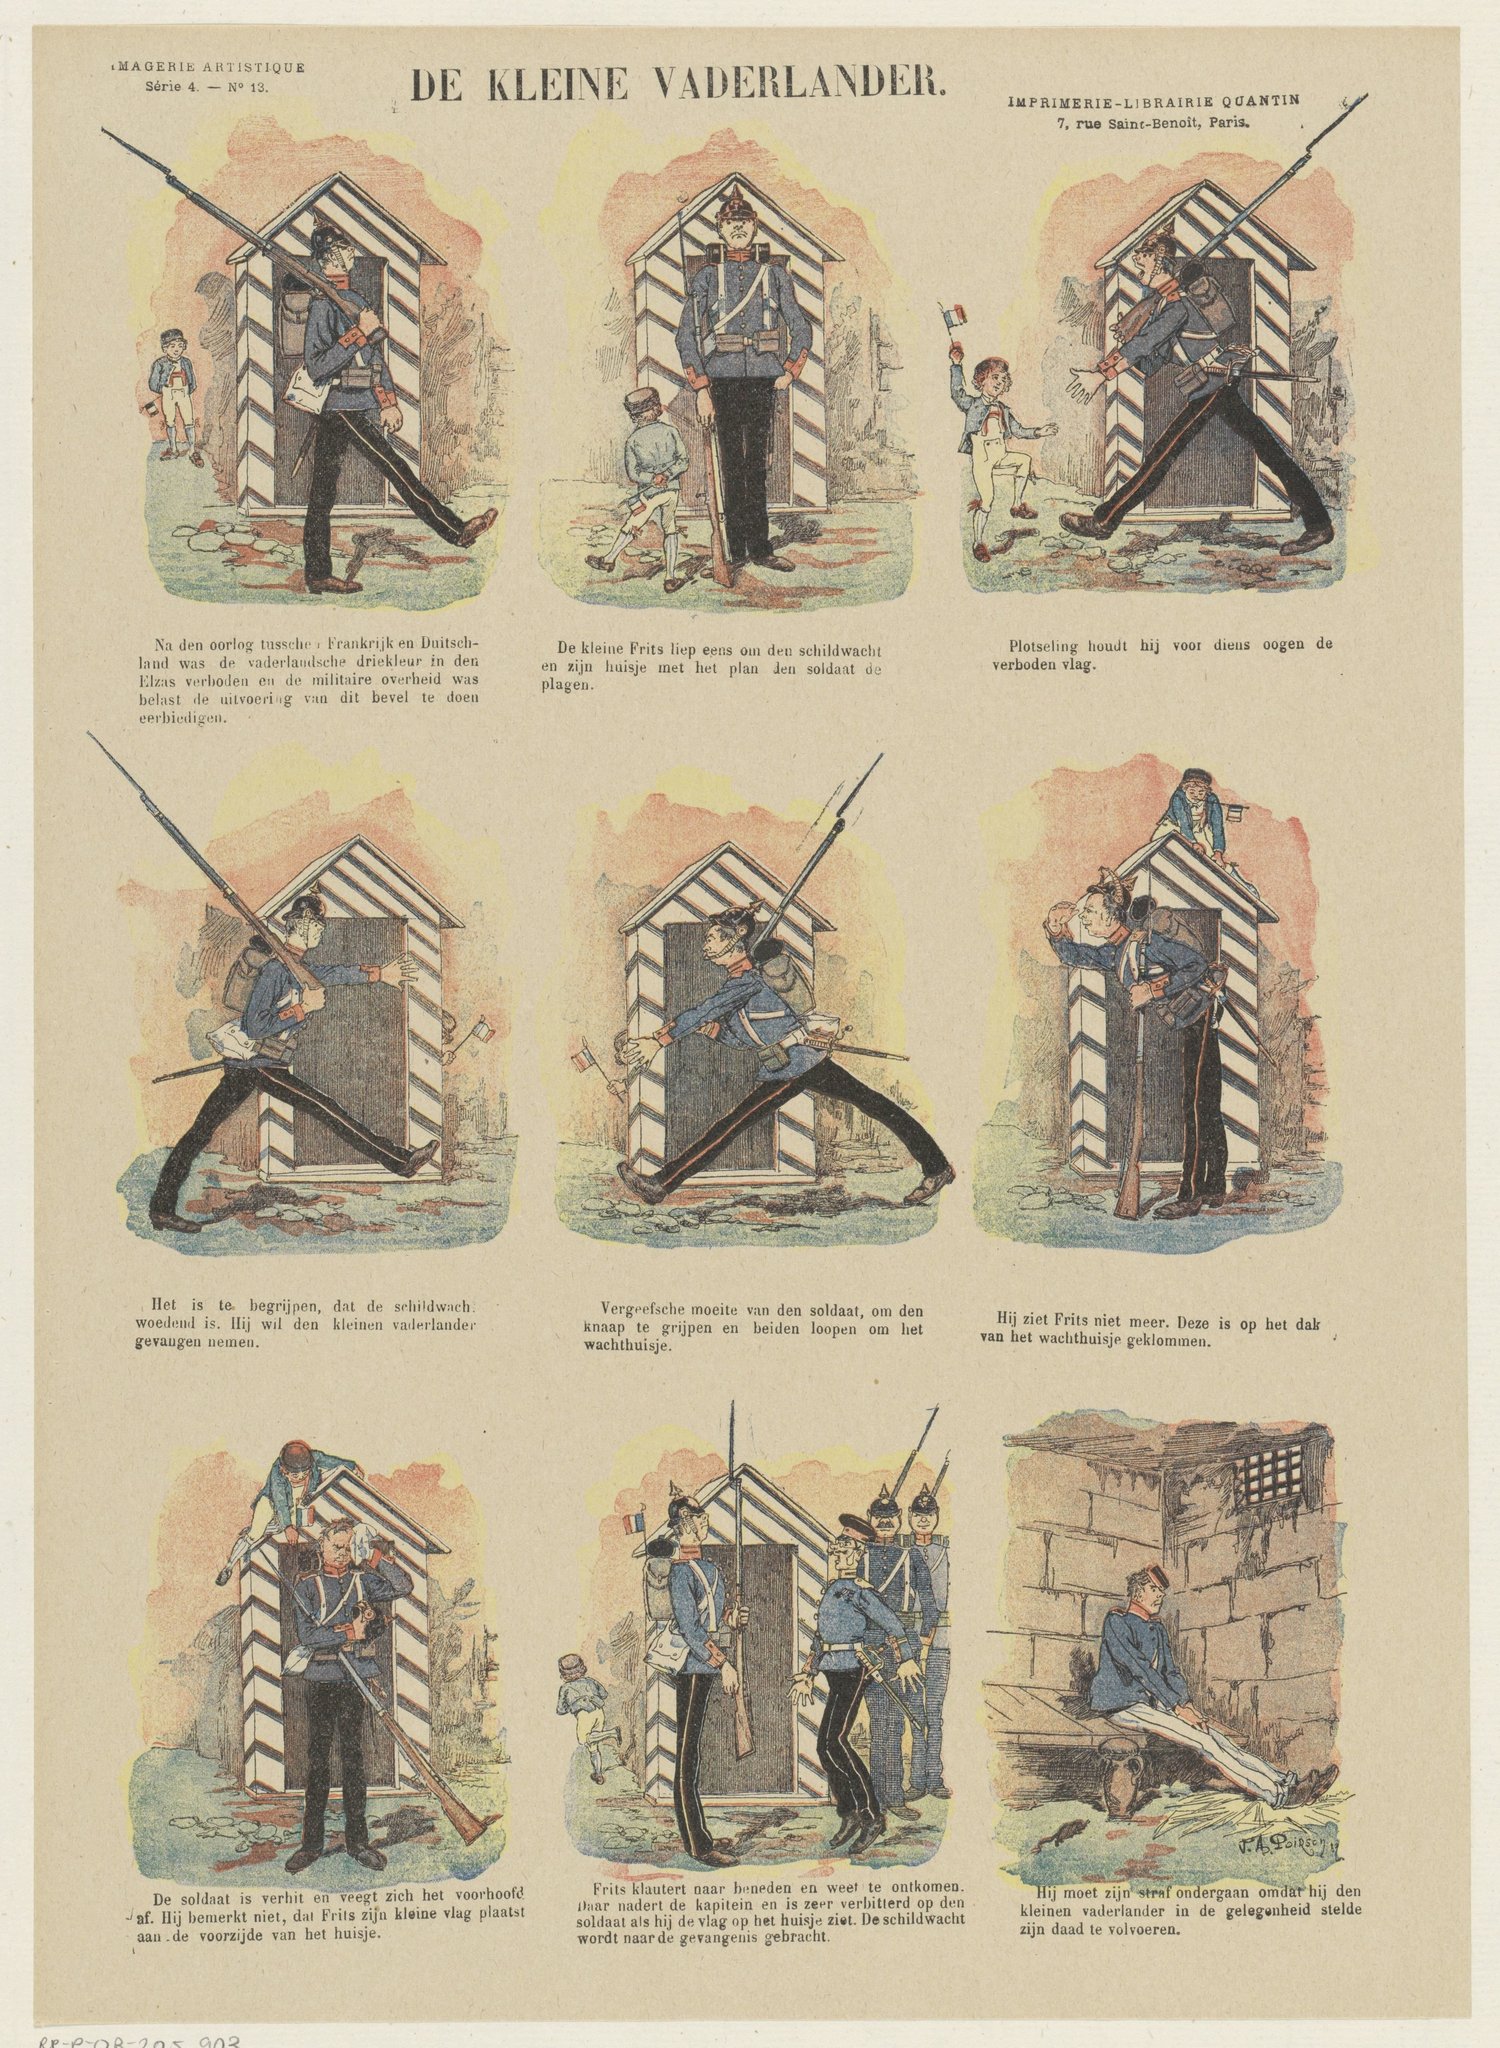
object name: print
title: Imagerie Artistique / Série 4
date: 1876-1890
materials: paper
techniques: lithograph, letterpress printing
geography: paris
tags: mischief-making play, tales and fairy tales, imprisonment, comedy, guard duty, keeping sentry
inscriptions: collector's mark: Lugt 2760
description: Blad met 9 voorstellingen van een kwajongen die een streek uithaalt met een wachter. Onder elke voorstelling een onderschrift. Genummerd linksboven: Série 4. - No. 13.